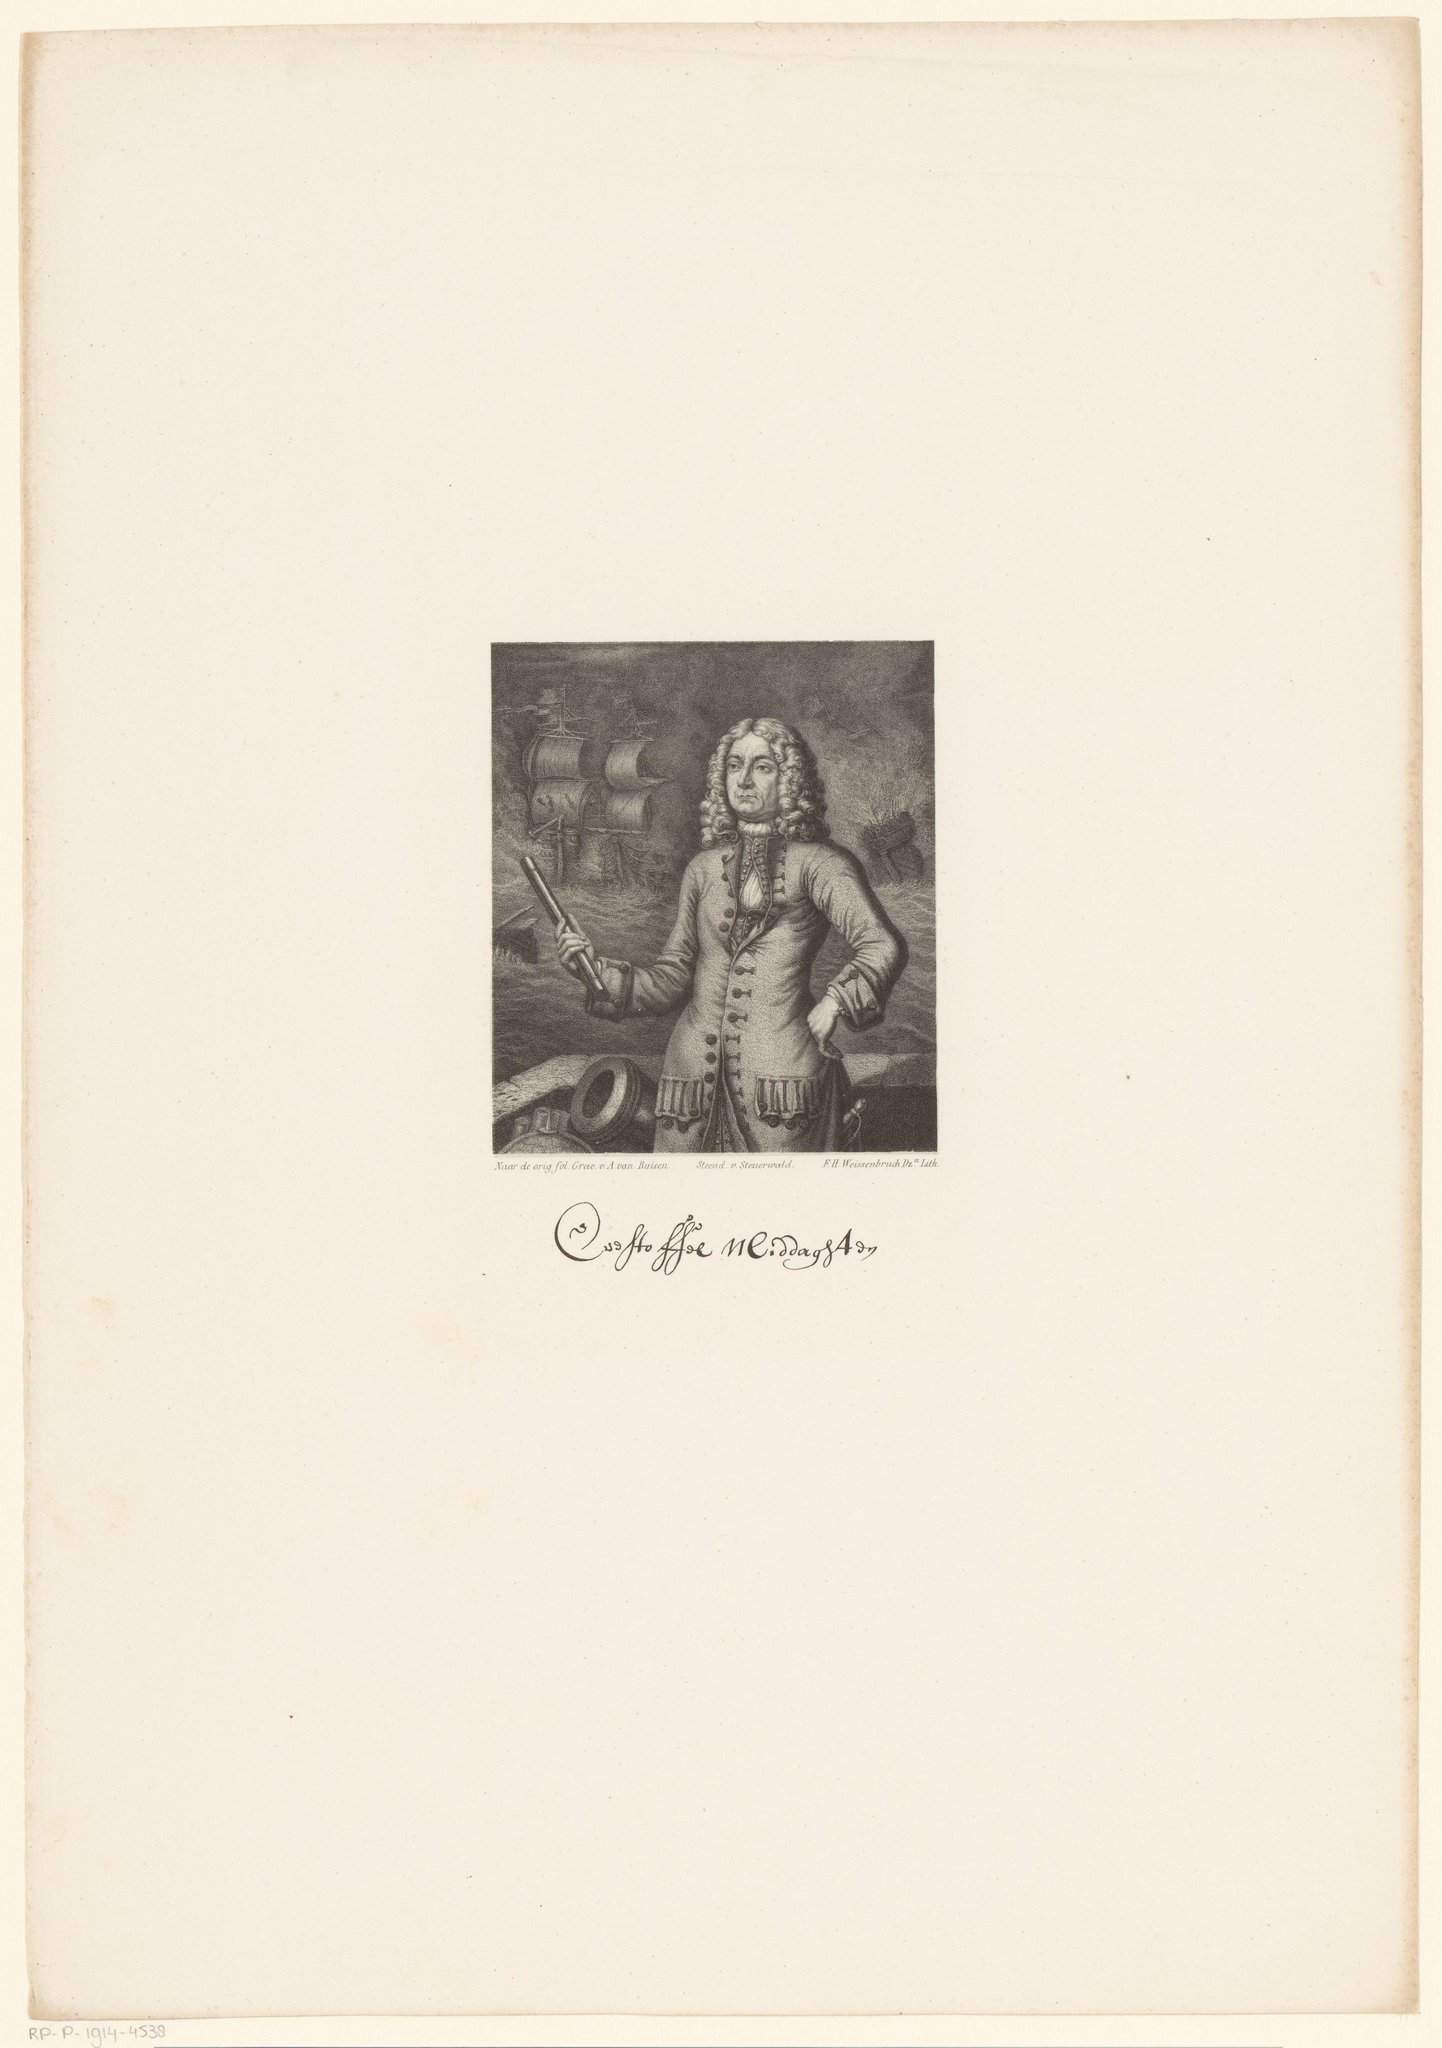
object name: book illustration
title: Portret van Christoffel Middaghten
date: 1858-1862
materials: paper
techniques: lithograph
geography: the hague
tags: historical persons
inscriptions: collector's mark: Lugt 2228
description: Prent uit: Jonge, J.C. de. Geschiedenis van het Nederlandsche zeewezen. Haarlem: Jonge, J.K.J. de, 1858-62.